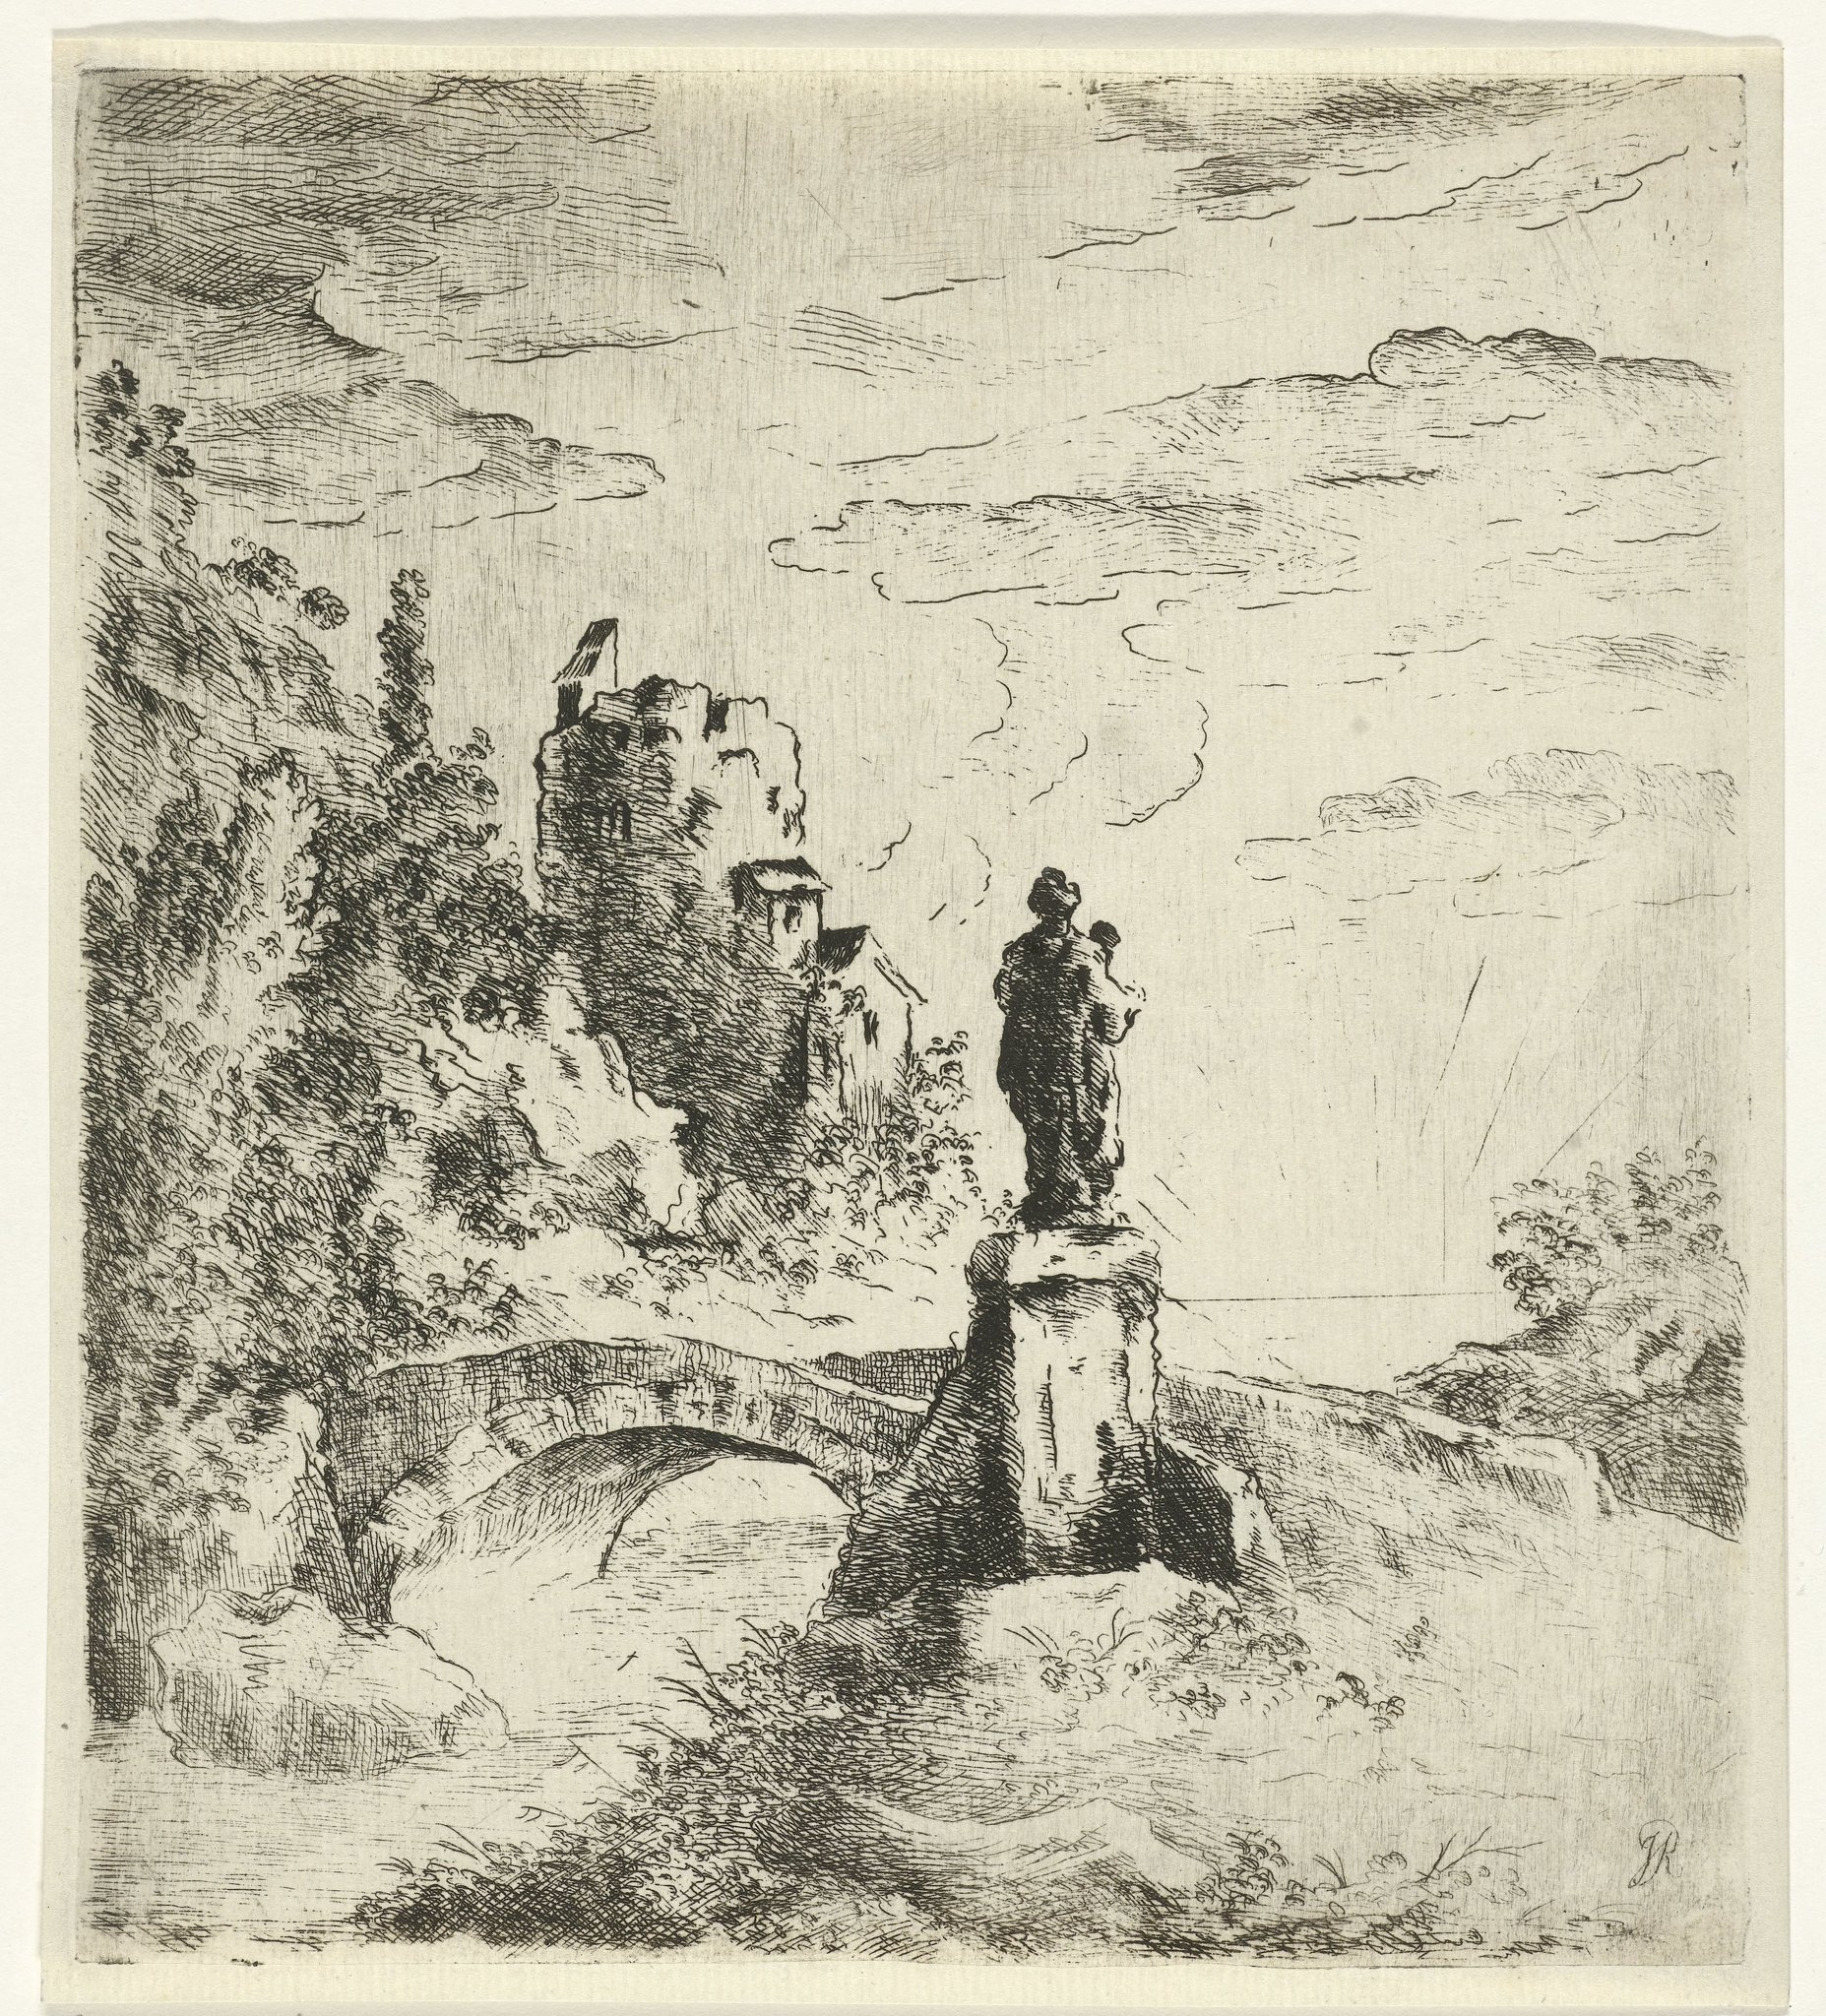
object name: print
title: Brug met standbeeld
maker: reinierus albertus ludovicus baron van isendoorn à blois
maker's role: print maker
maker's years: 1786-1856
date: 1796-1856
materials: paper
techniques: etching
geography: vaassen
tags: landscape with bridge, viaduct or aqueduct, monument, statue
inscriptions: collector's mark: Lugt 2228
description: Een gebogen brug over het water. Rechts daarvan een standbeeld op een pedestal, vermoedelijk Maria met kind, op de rug gezien. Links een berg en een rond gebouw.